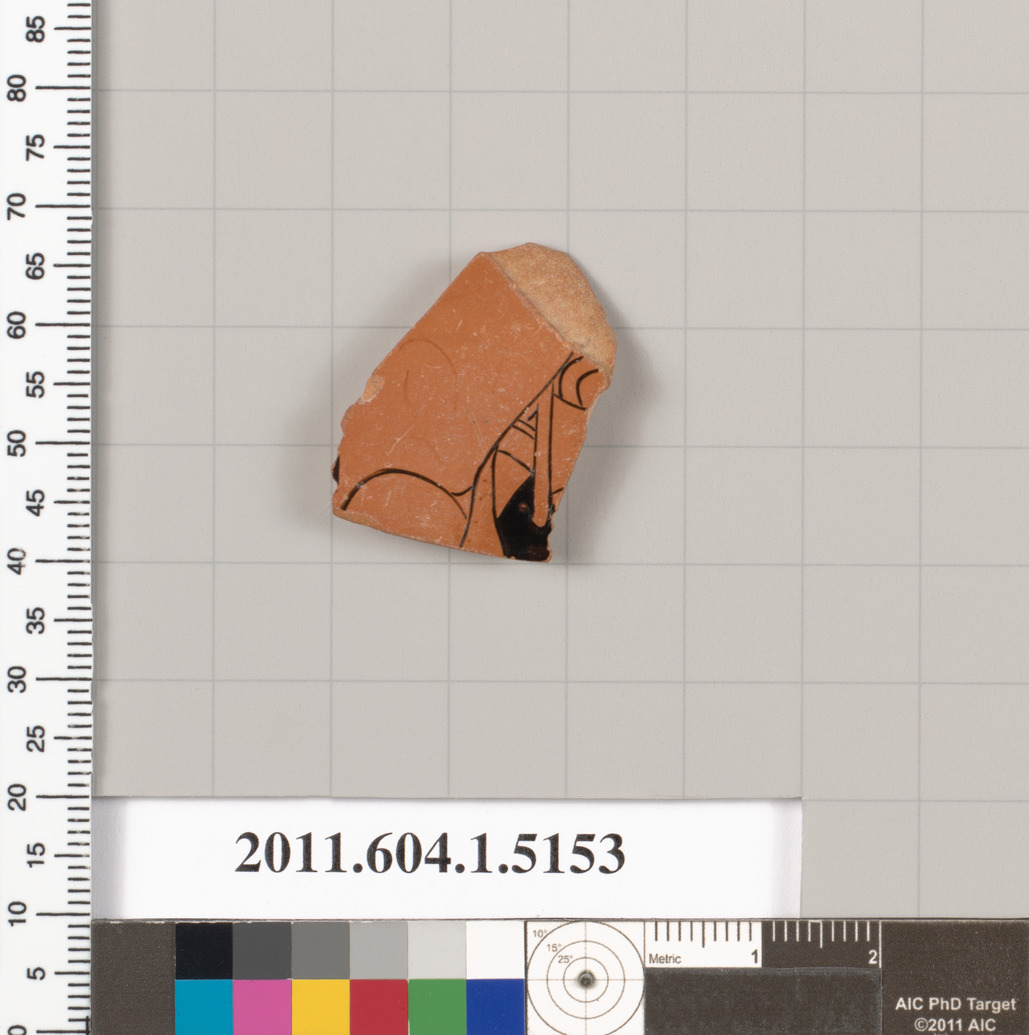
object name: kylix fragment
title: Terracotta fragment of a kylix (drinking cup)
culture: greek, attic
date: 500-480 BCE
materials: terracotta